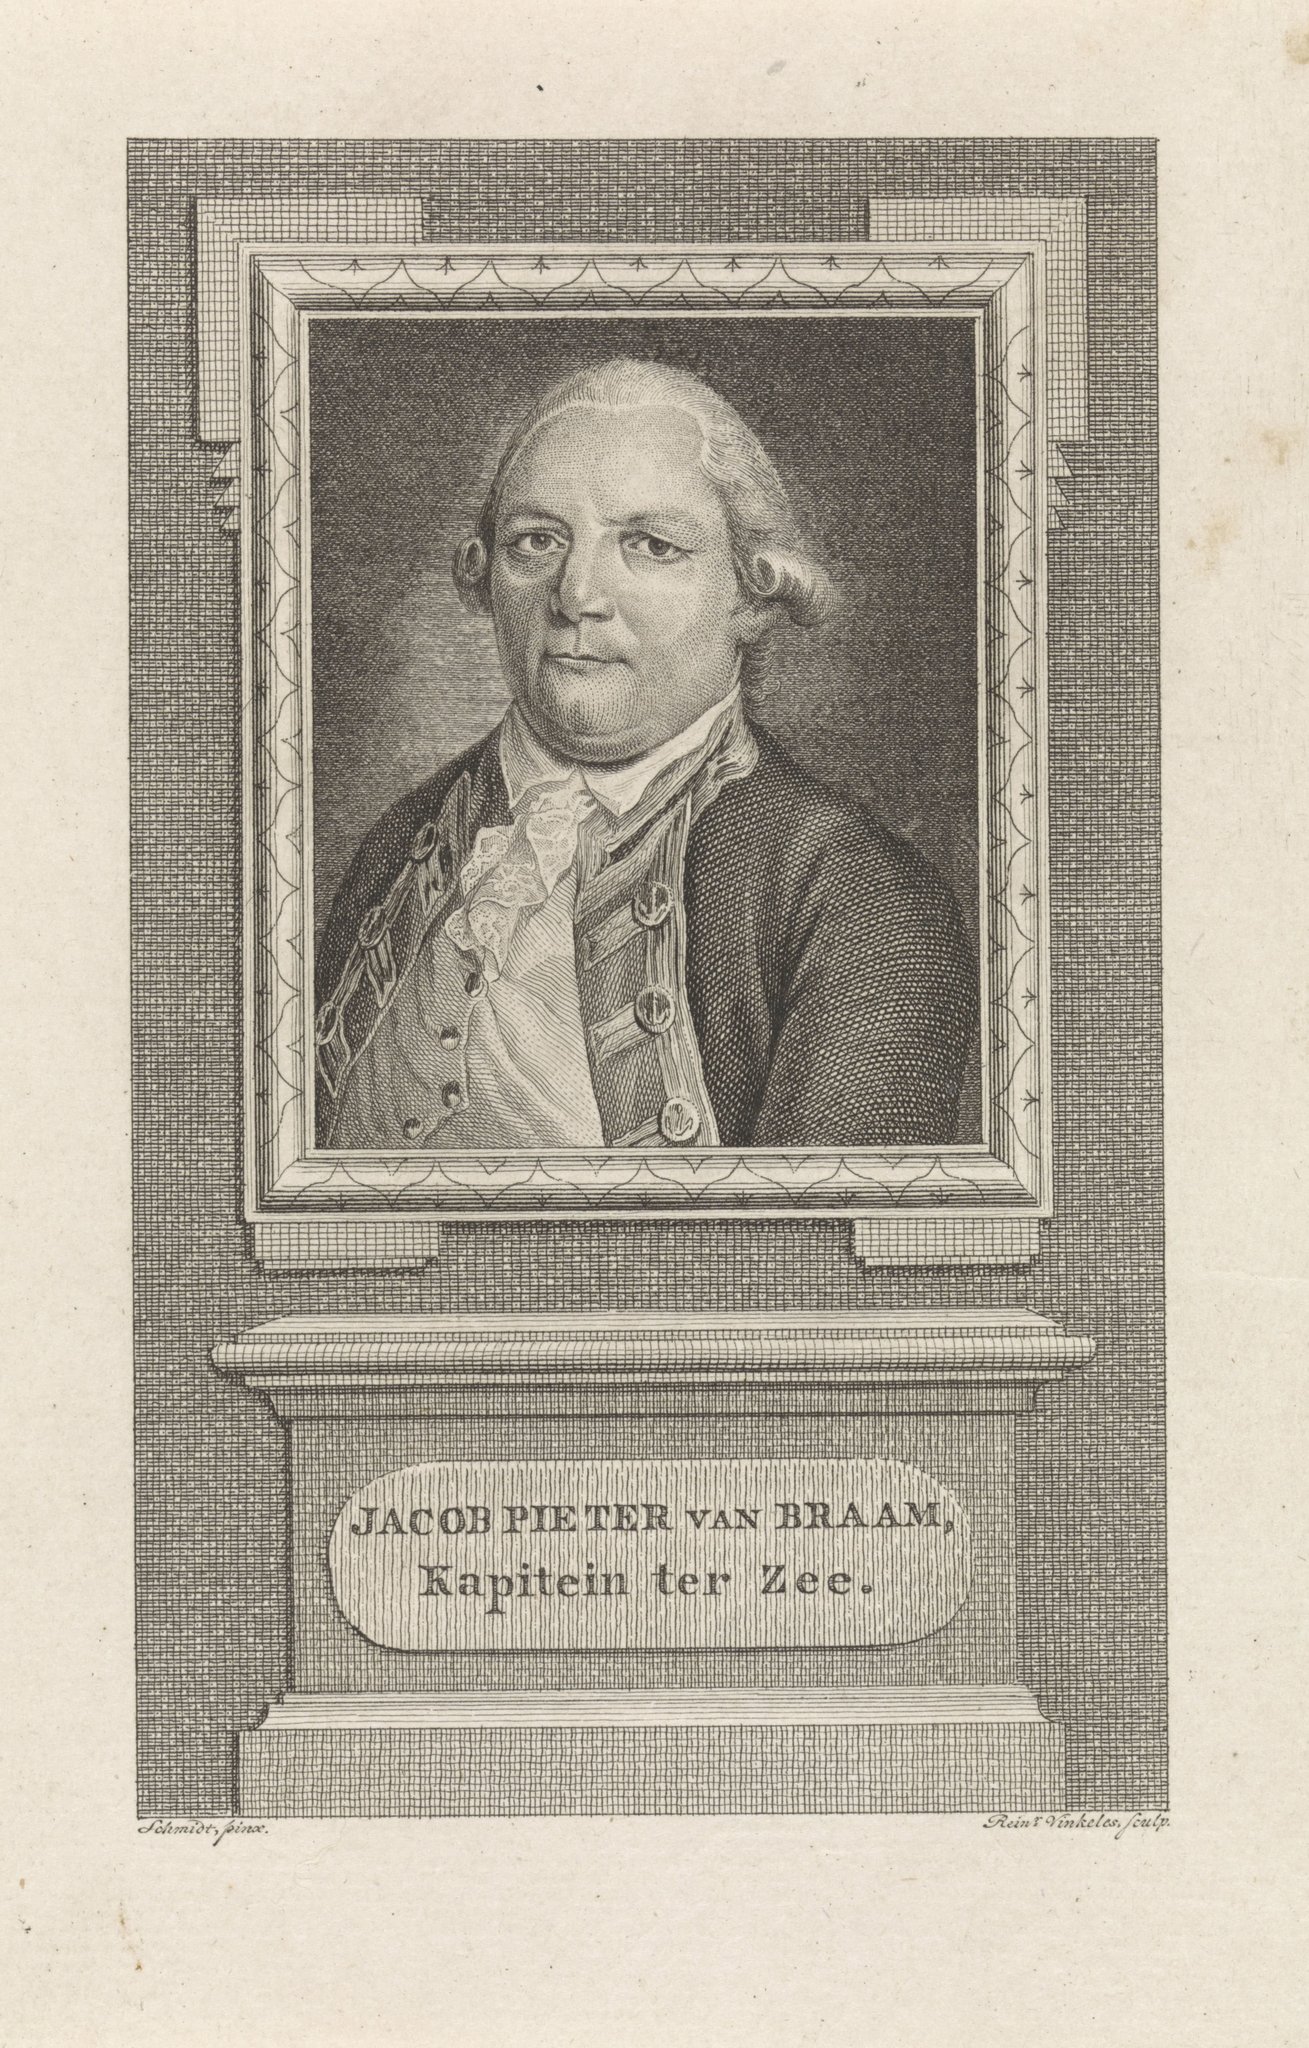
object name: print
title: Portret van Jacob Pieter van Braam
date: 1786-1809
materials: paper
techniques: engraving, etching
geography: amsterdam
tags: werkhoven, zwolle, jacob pieter van braam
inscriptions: collector's mark: Lugt 2228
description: Prent ook gebruikt als boekillustratie in: Wagenaar, Jan. Vaderlandsche historie, (...) ten vervolge van Wagenaars Vaderlandsche historie. Dl. 1-43. Amsterdam: Johannes Allart, 1786-1809.